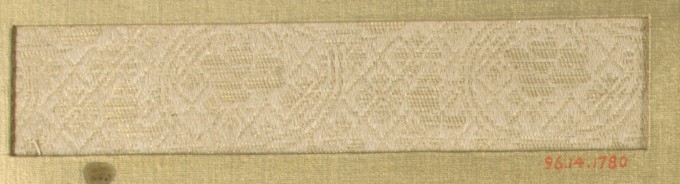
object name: piece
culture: japanese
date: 1701-1900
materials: silk